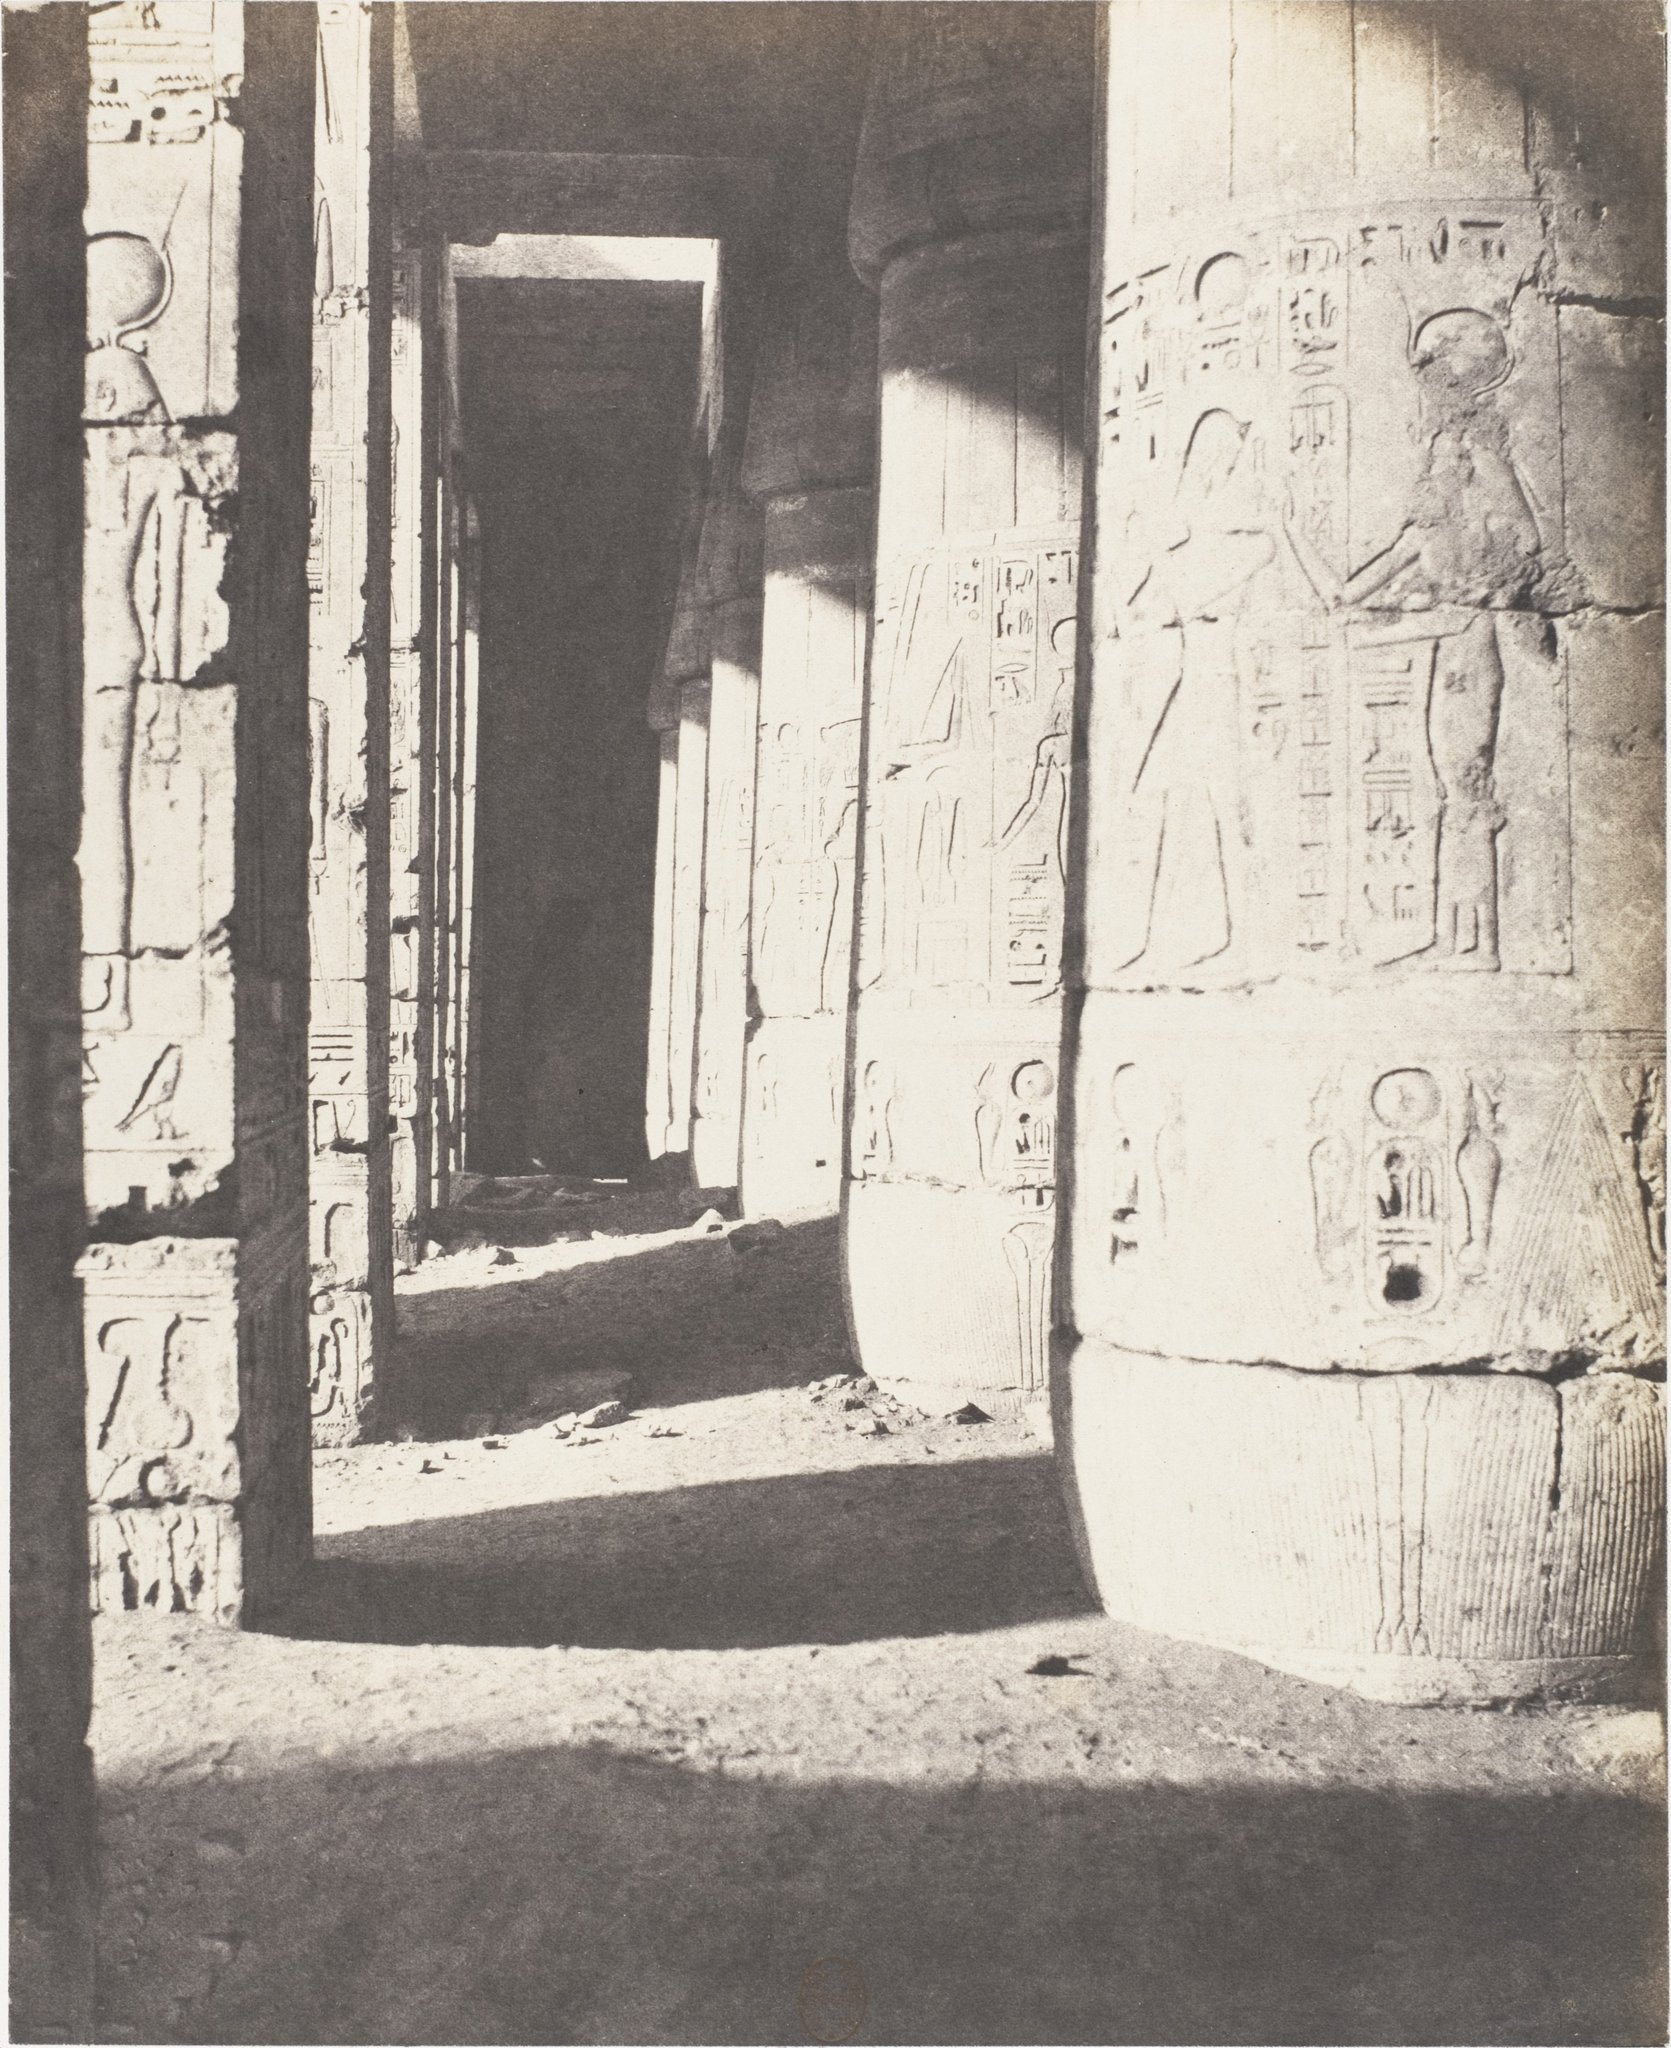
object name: photograph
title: Médînet-Abou (Thèbes), Constructions Postérieures - Deuxieme Cour - Galerie Nord-Ouest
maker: félix teynard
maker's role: artist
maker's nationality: french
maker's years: 1817-1892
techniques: paper negative, salted paper print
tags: architecture,columns